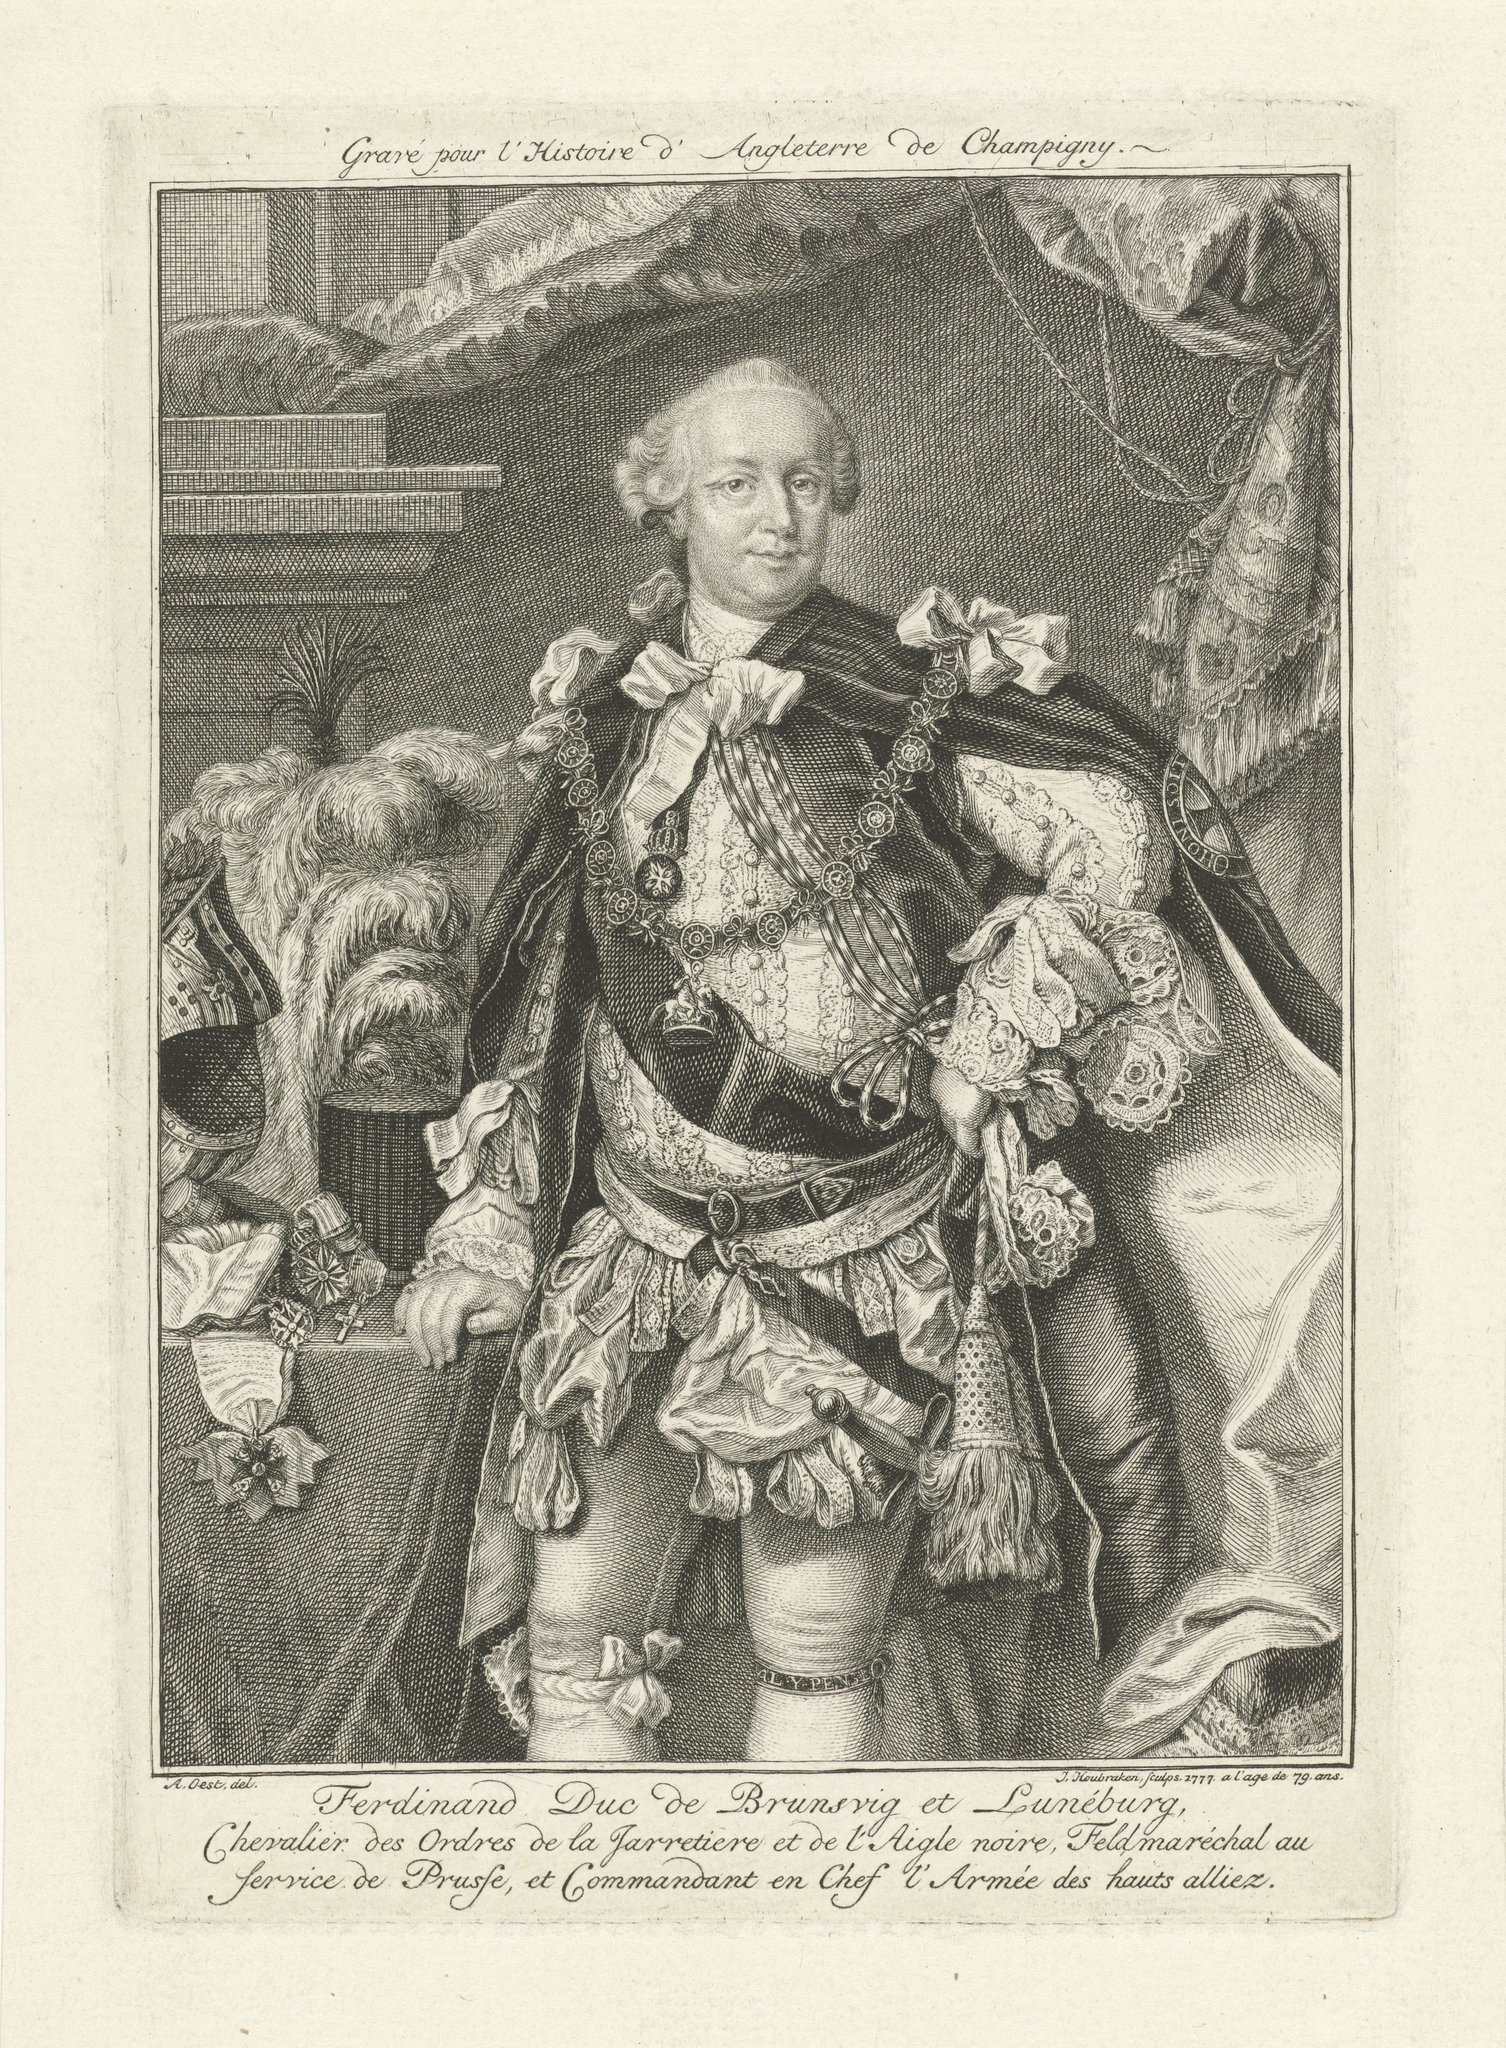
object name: print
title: Portret van Ferdinand hertog van Brunswijk-Lüneburg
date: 1777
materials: paper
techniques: engraving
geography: amsterdam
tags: commander-in-chief, general, marshal, warfare; military affairs (+ commander-in-chief)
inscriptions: collector's mark: Lugt 240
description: Kniestuk van Ferdinand hertog van Brunswijk-Lüneburg in militair uniform, in een interieur. Zijn rechterhand leunt op een tafel naast hem, waarop diverse insignes en een helm. Onder het portret zijn naam en gegevens in drie regels in het Frans.